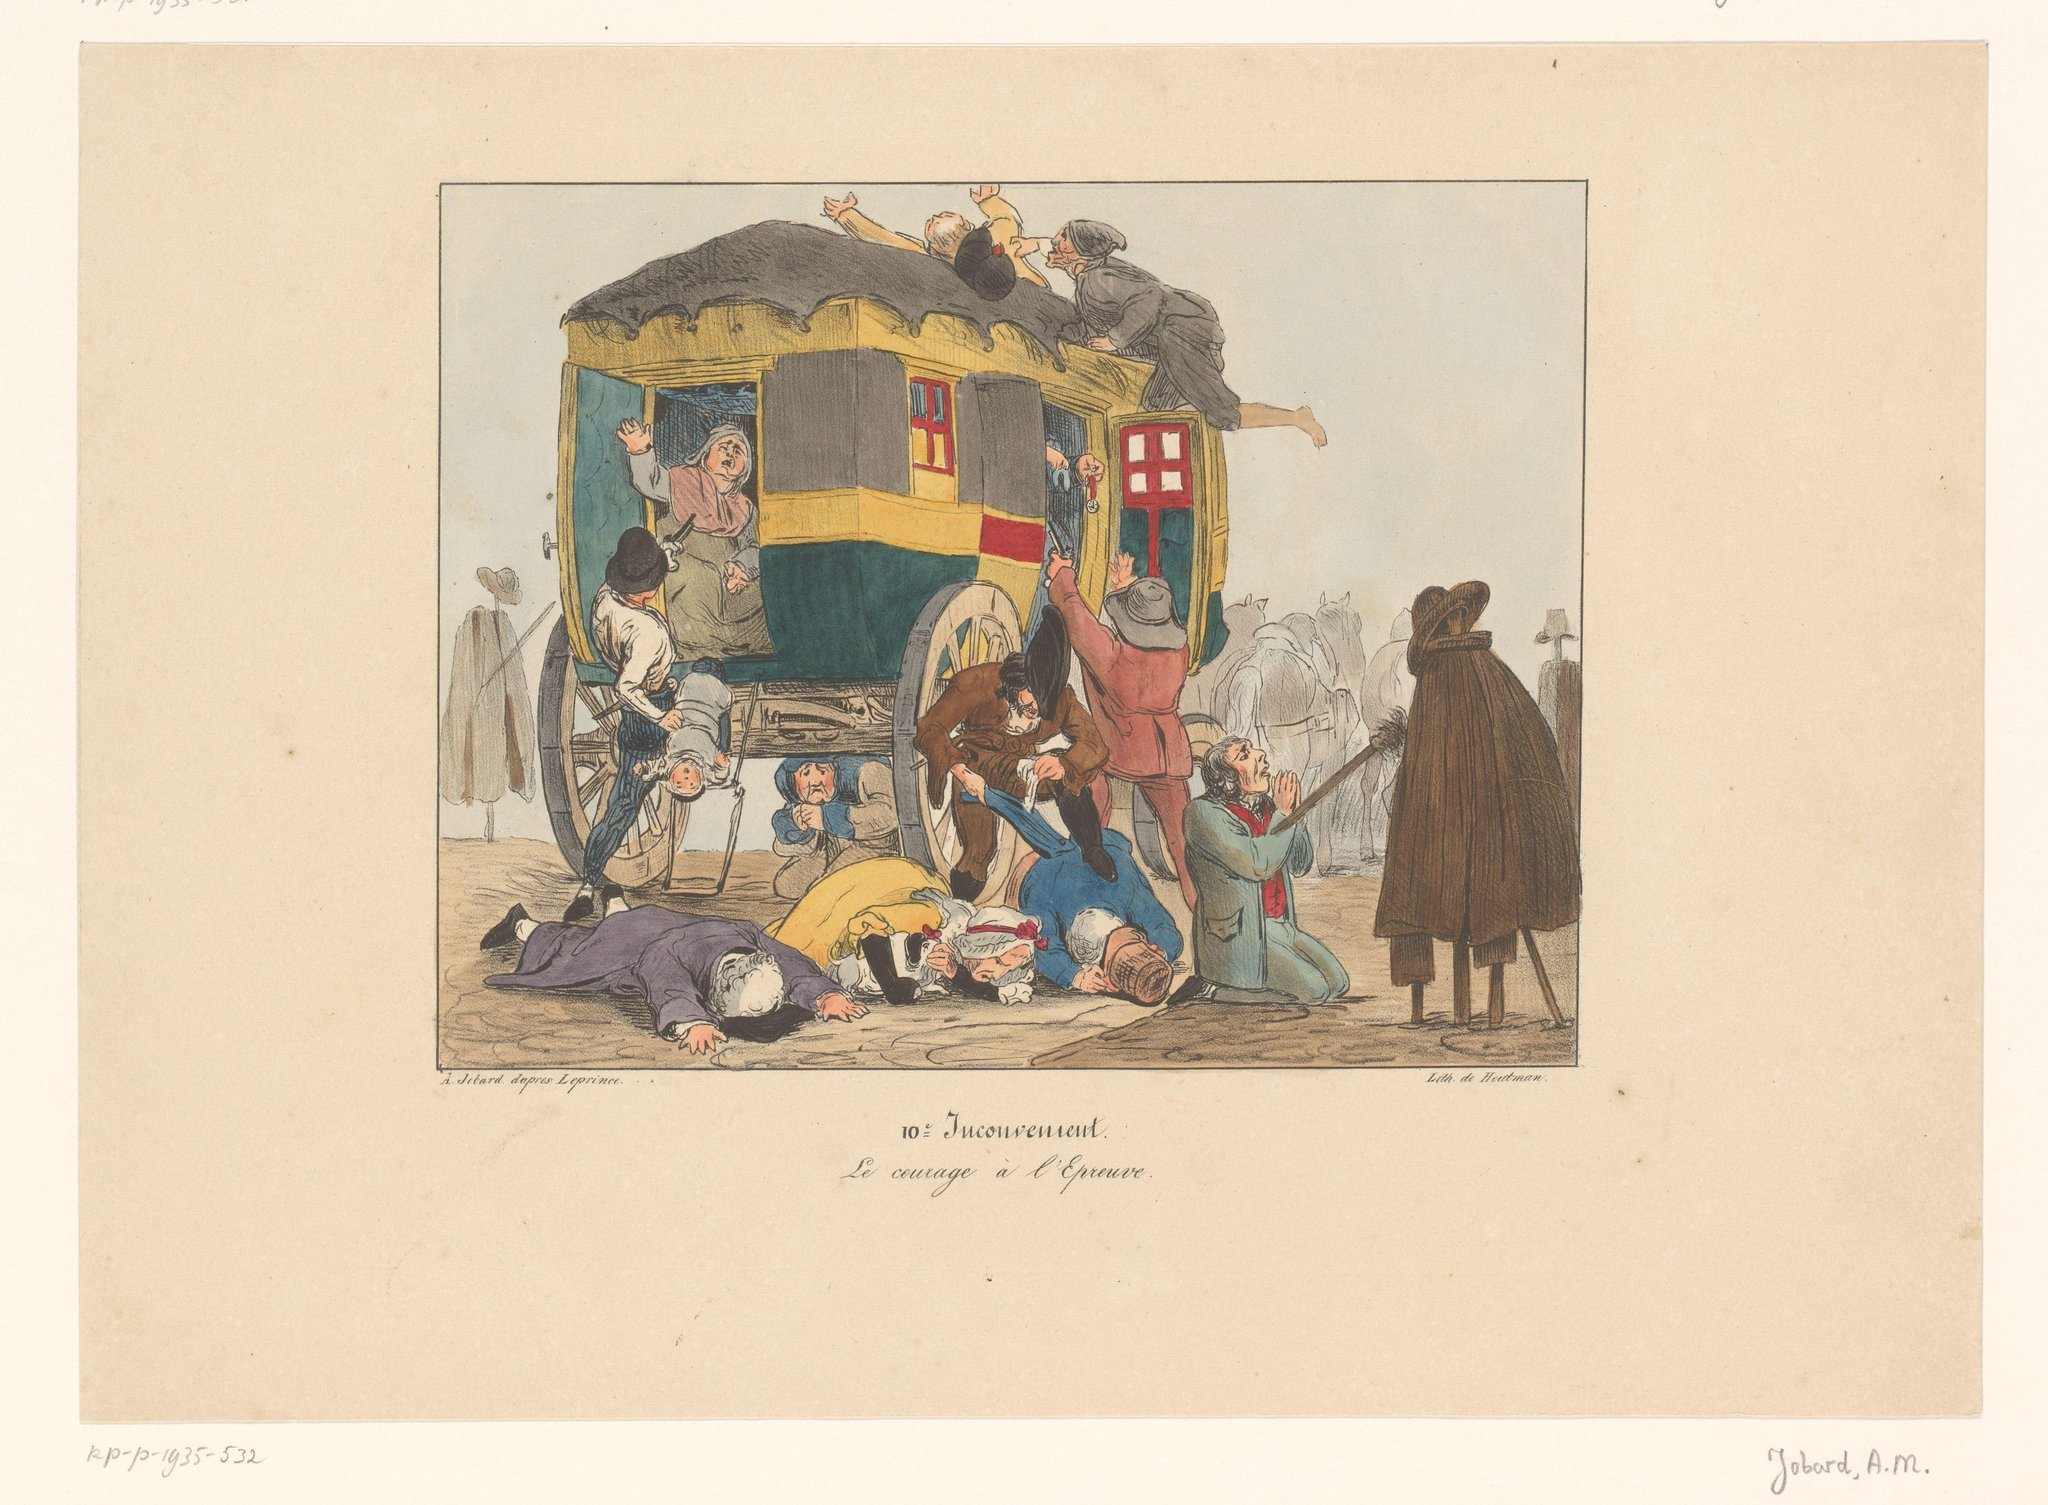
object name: cartoon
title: Ongemakken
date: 1826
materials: paper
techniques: hand coloring, lithograph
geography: utrecht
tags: diligence, omnibus, horse-tram, traveller(s) attacked by robber(s), robbery, passenger carriage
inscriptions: collector's mark: Lugt 2760, collector's mark: Lugt 2228a